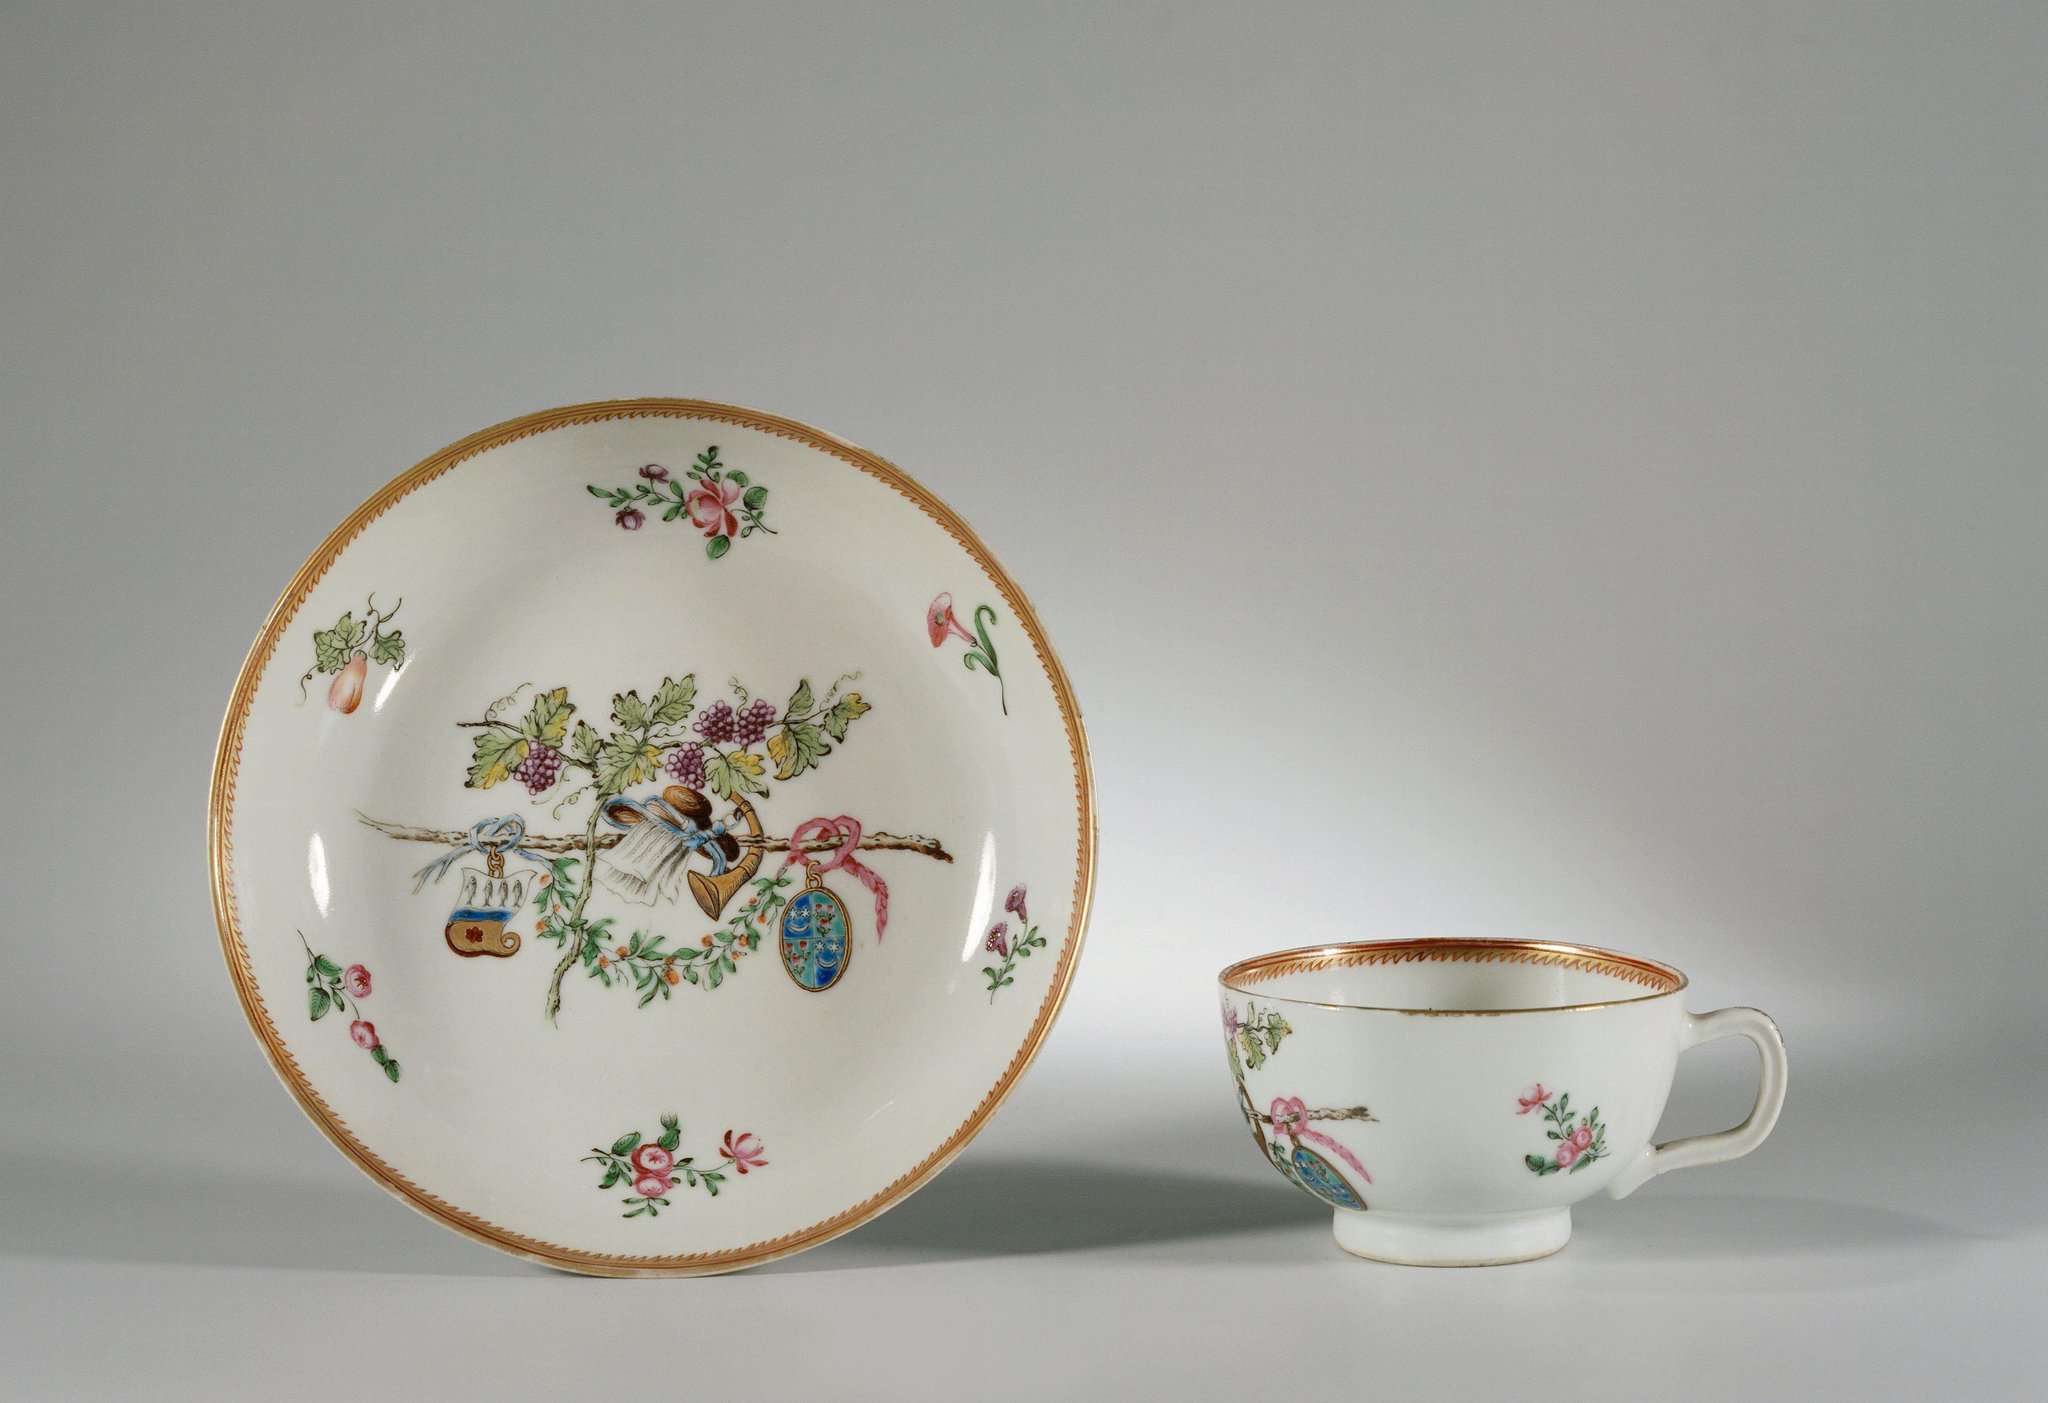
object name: platter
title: Saucer with the arms of the Visvliet and Sluymer families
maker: Anonymous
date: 1777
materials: glaze, gold, paint, porcelain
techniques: firing, gilding, turning, vitrification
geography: china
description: In het centrum hangen twee wapens, verbonden door een guirlande, aan bloem- en vruchtentakken. Het wapen links is van de familie Van Visvliet en is opgedeeld in twee velden met vissen en een roos. Het wapen rechts is van de familie Sluijmer en is opgedeeld in vier velden, met hemellichamen, en rode bloemen. Aan de takken zijn, behalve de wapens, een dameshoed, een blad papier en een hoorn bevestigd. De kop en schotel zijn verder versierd met strooibloemen en een rand in goud.